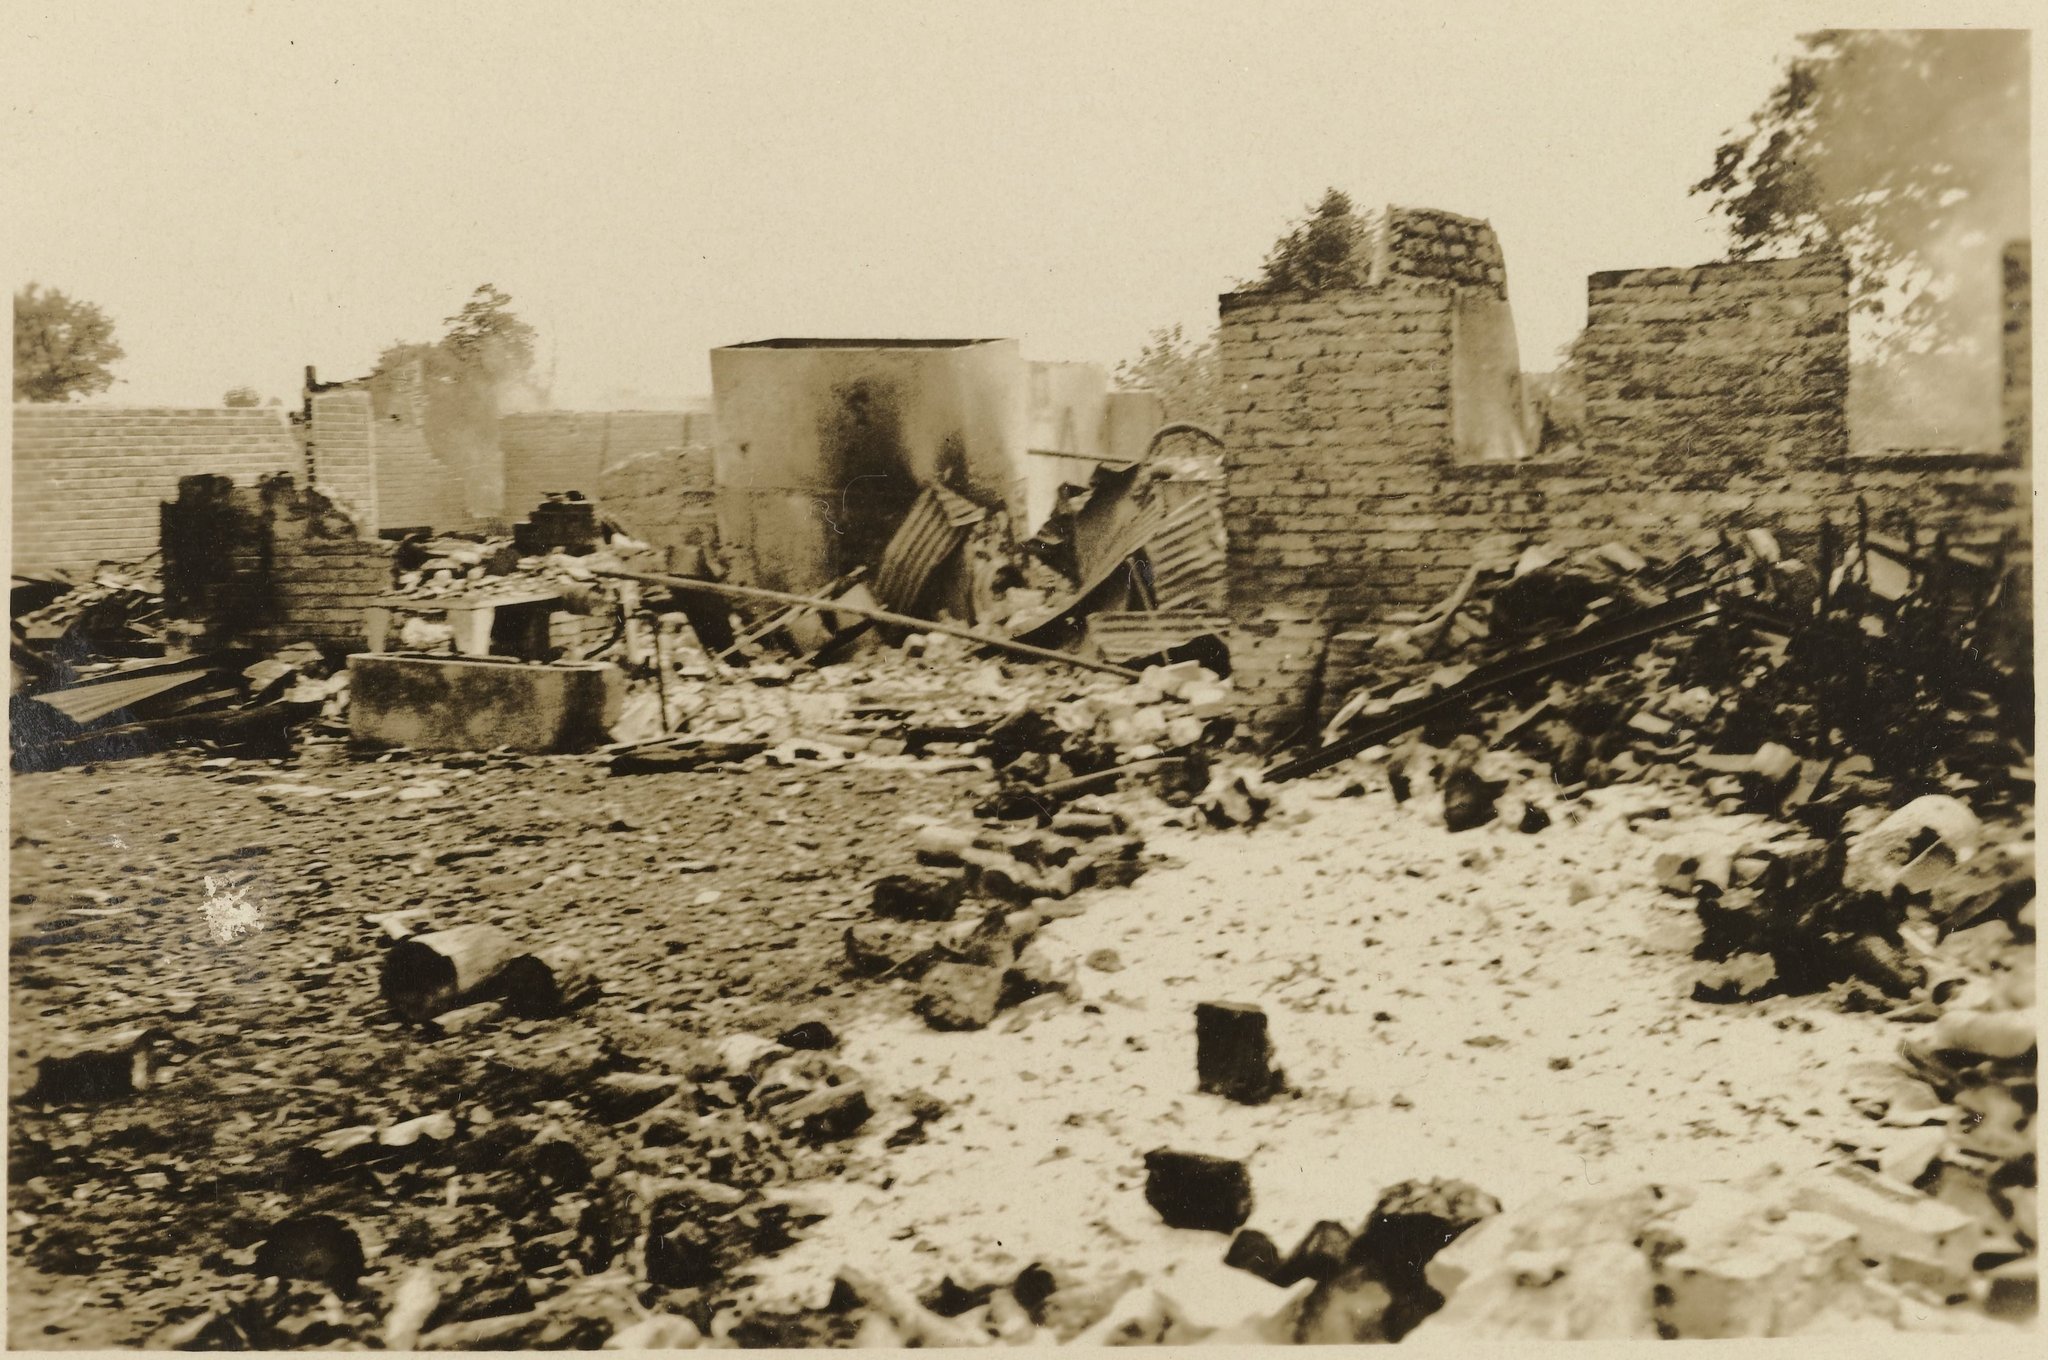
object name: photograph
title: Geruïneerde huizen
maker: Anonymous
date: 1940-1945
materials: photographic support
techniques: gelatin silver print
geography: czechoslovakia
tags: netherlands, germany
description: Geruïneerde huizen. Foto behorend bij album 'Kriegserinnerungen'.